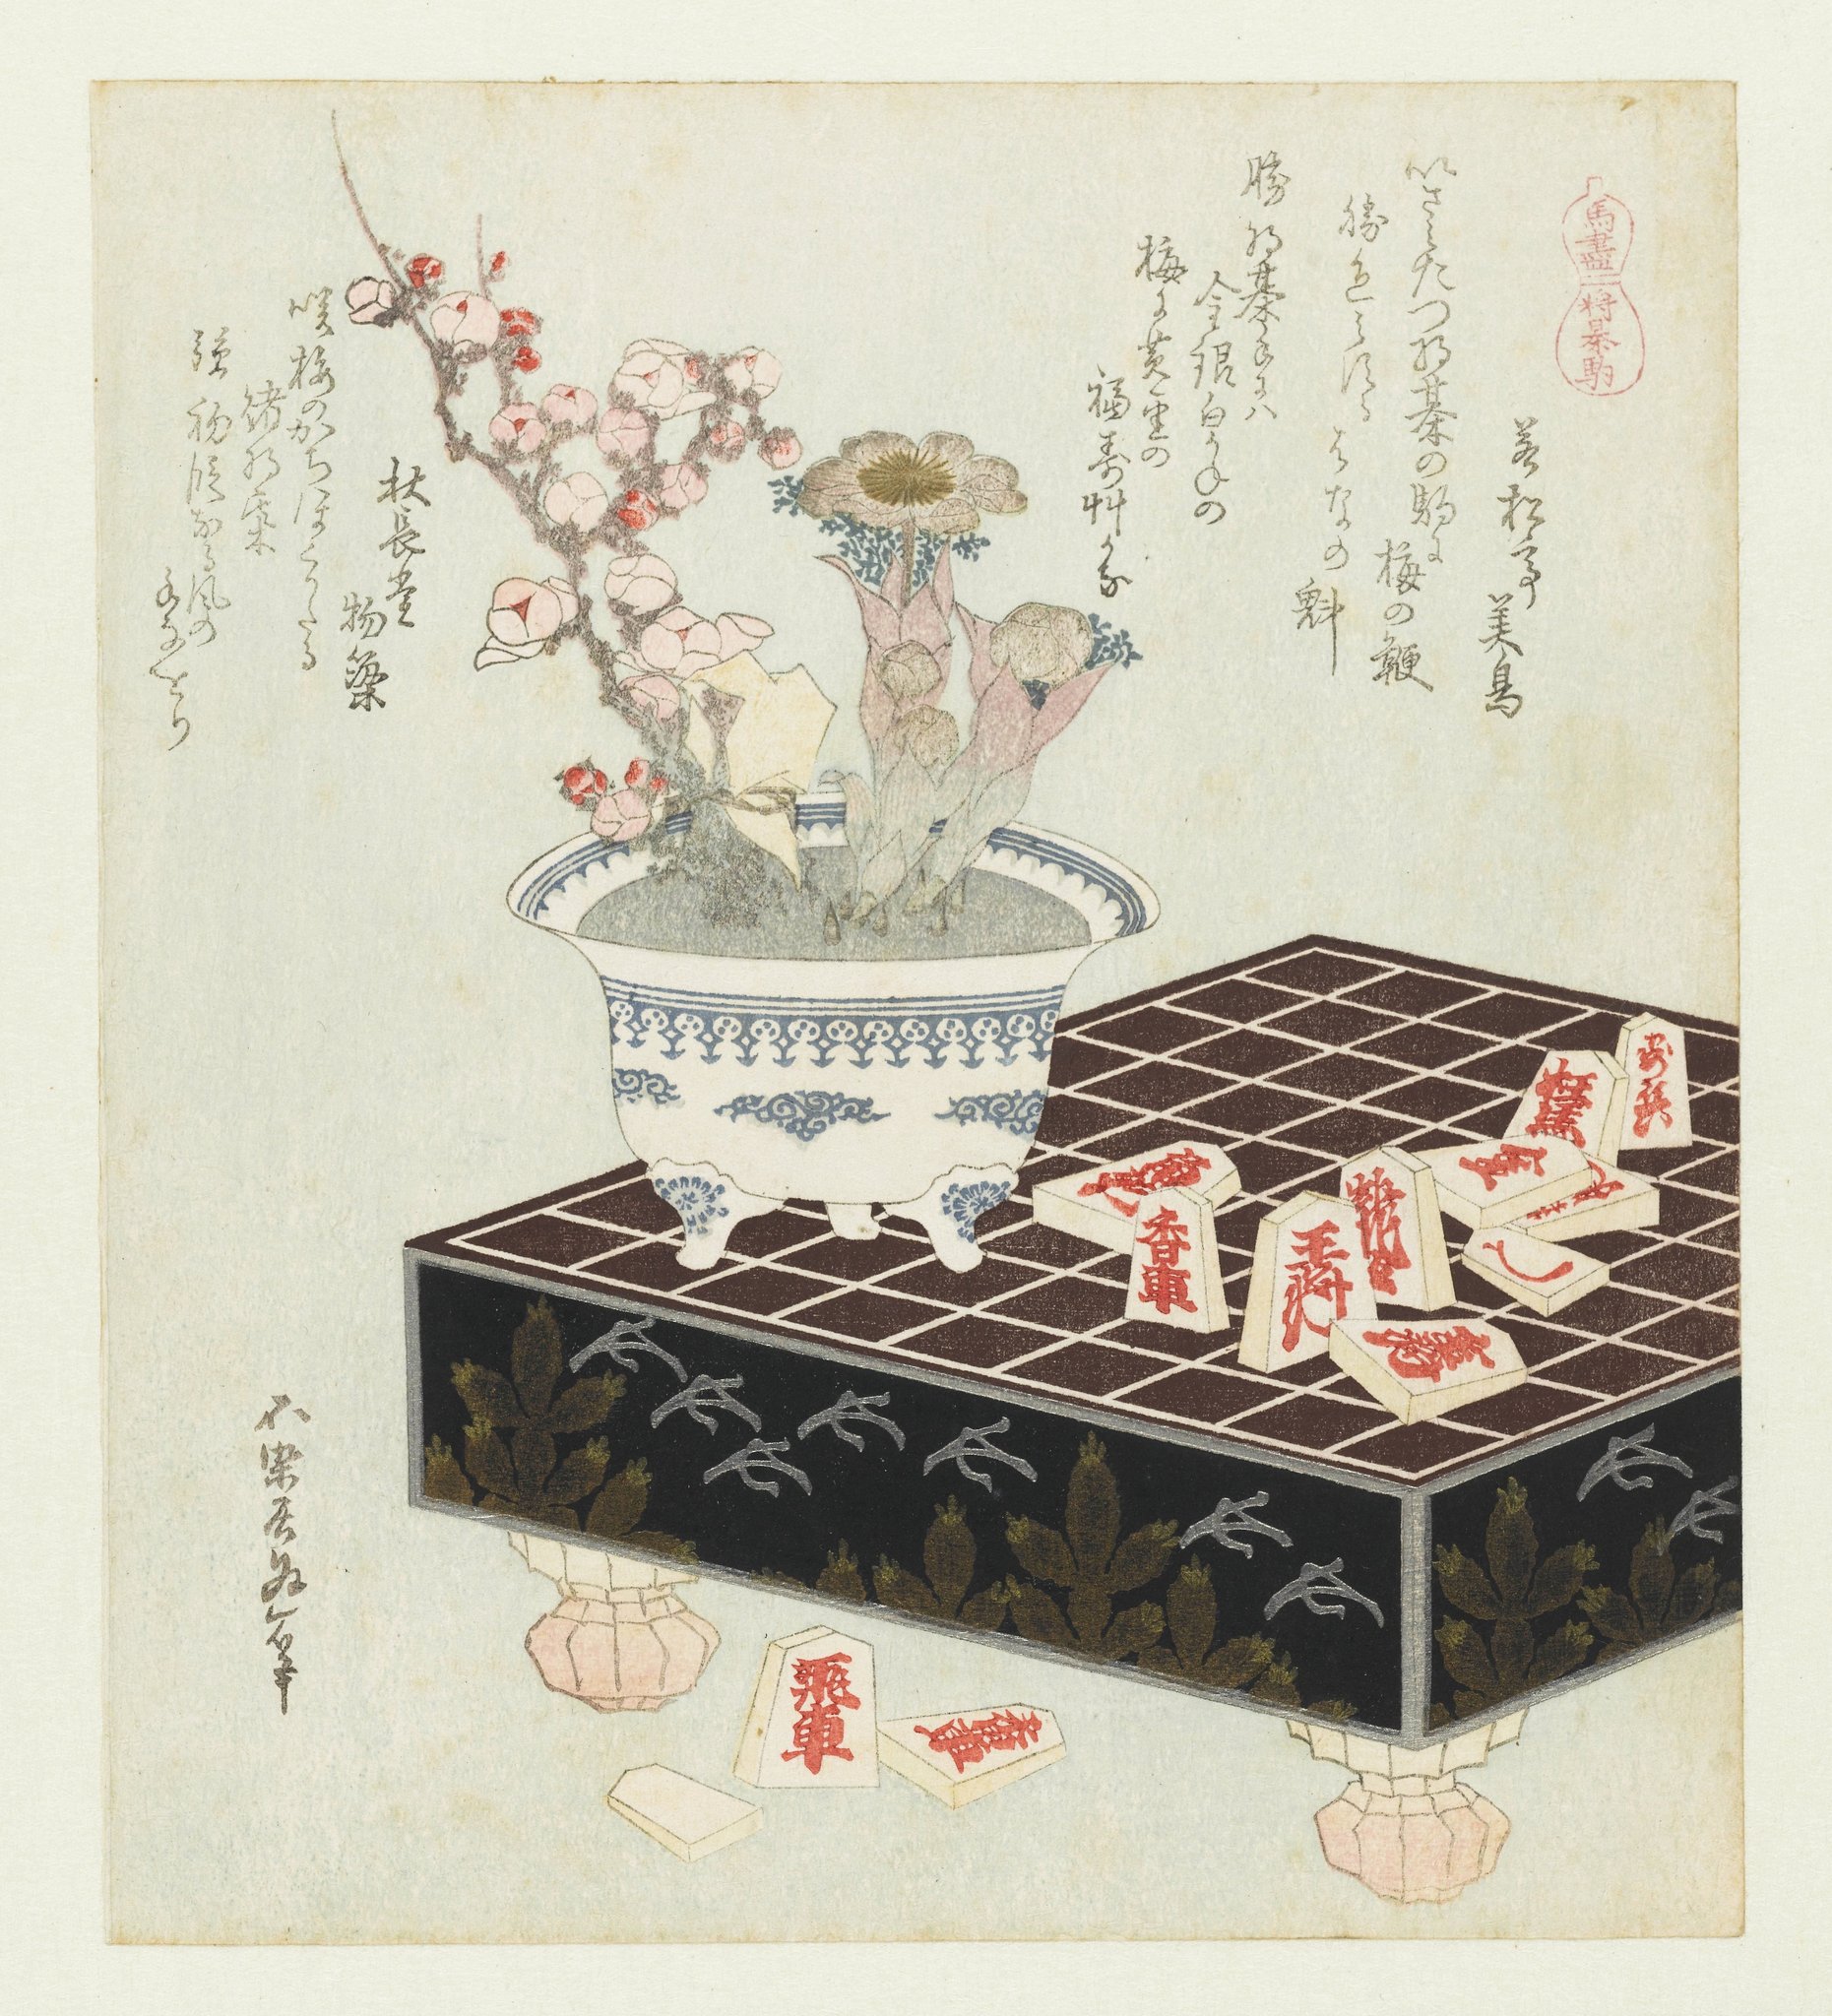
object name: surimono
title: Shogikoma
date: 1822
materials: paper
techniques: blind stamped, woodcut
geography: japan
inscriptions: collector's mark, verso, stamped: Lugt 2228, collector's mark, passe-partout, bottom left, printed: JABdH with a rooster.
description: Een surimono is een luxe uitgevoerde prent waarop beeld met één of meerdere gedichten gecombineerd is. Bij het drukken van een surimono werd vaak gebruik gemaakt van dikker papier, blinddruk en metaal pigmenten, zoals koper- en zilverpoeder. De prenten werden vaak in opdracht van dichters gemaakt en als exclusief geschenk aan vrienden en relaties gegeven.